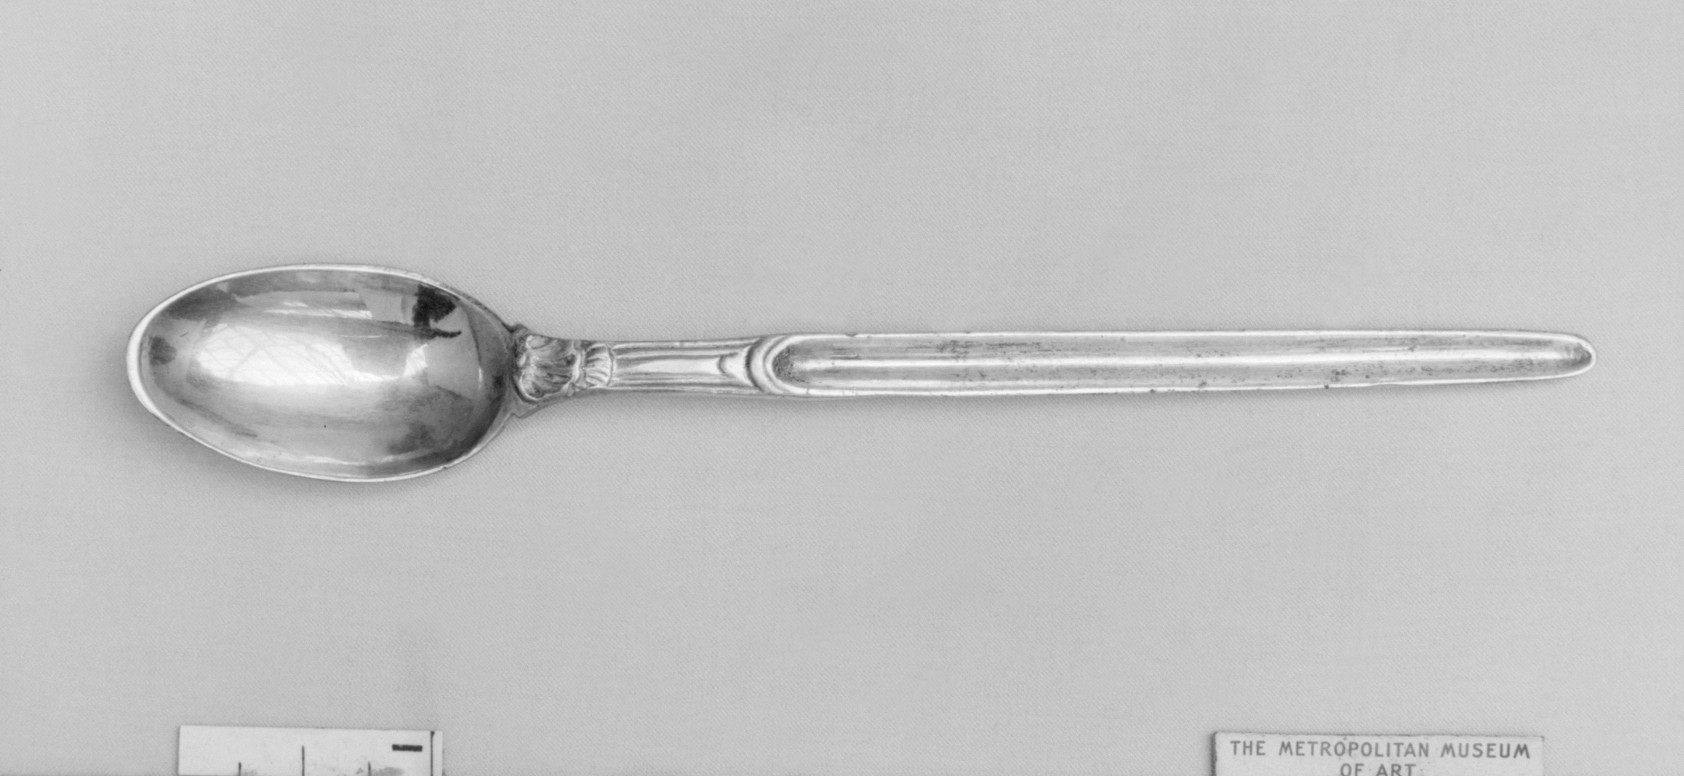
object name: marrow spoon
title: Marrow (?) spoon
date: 1701-1750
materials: silver gilt